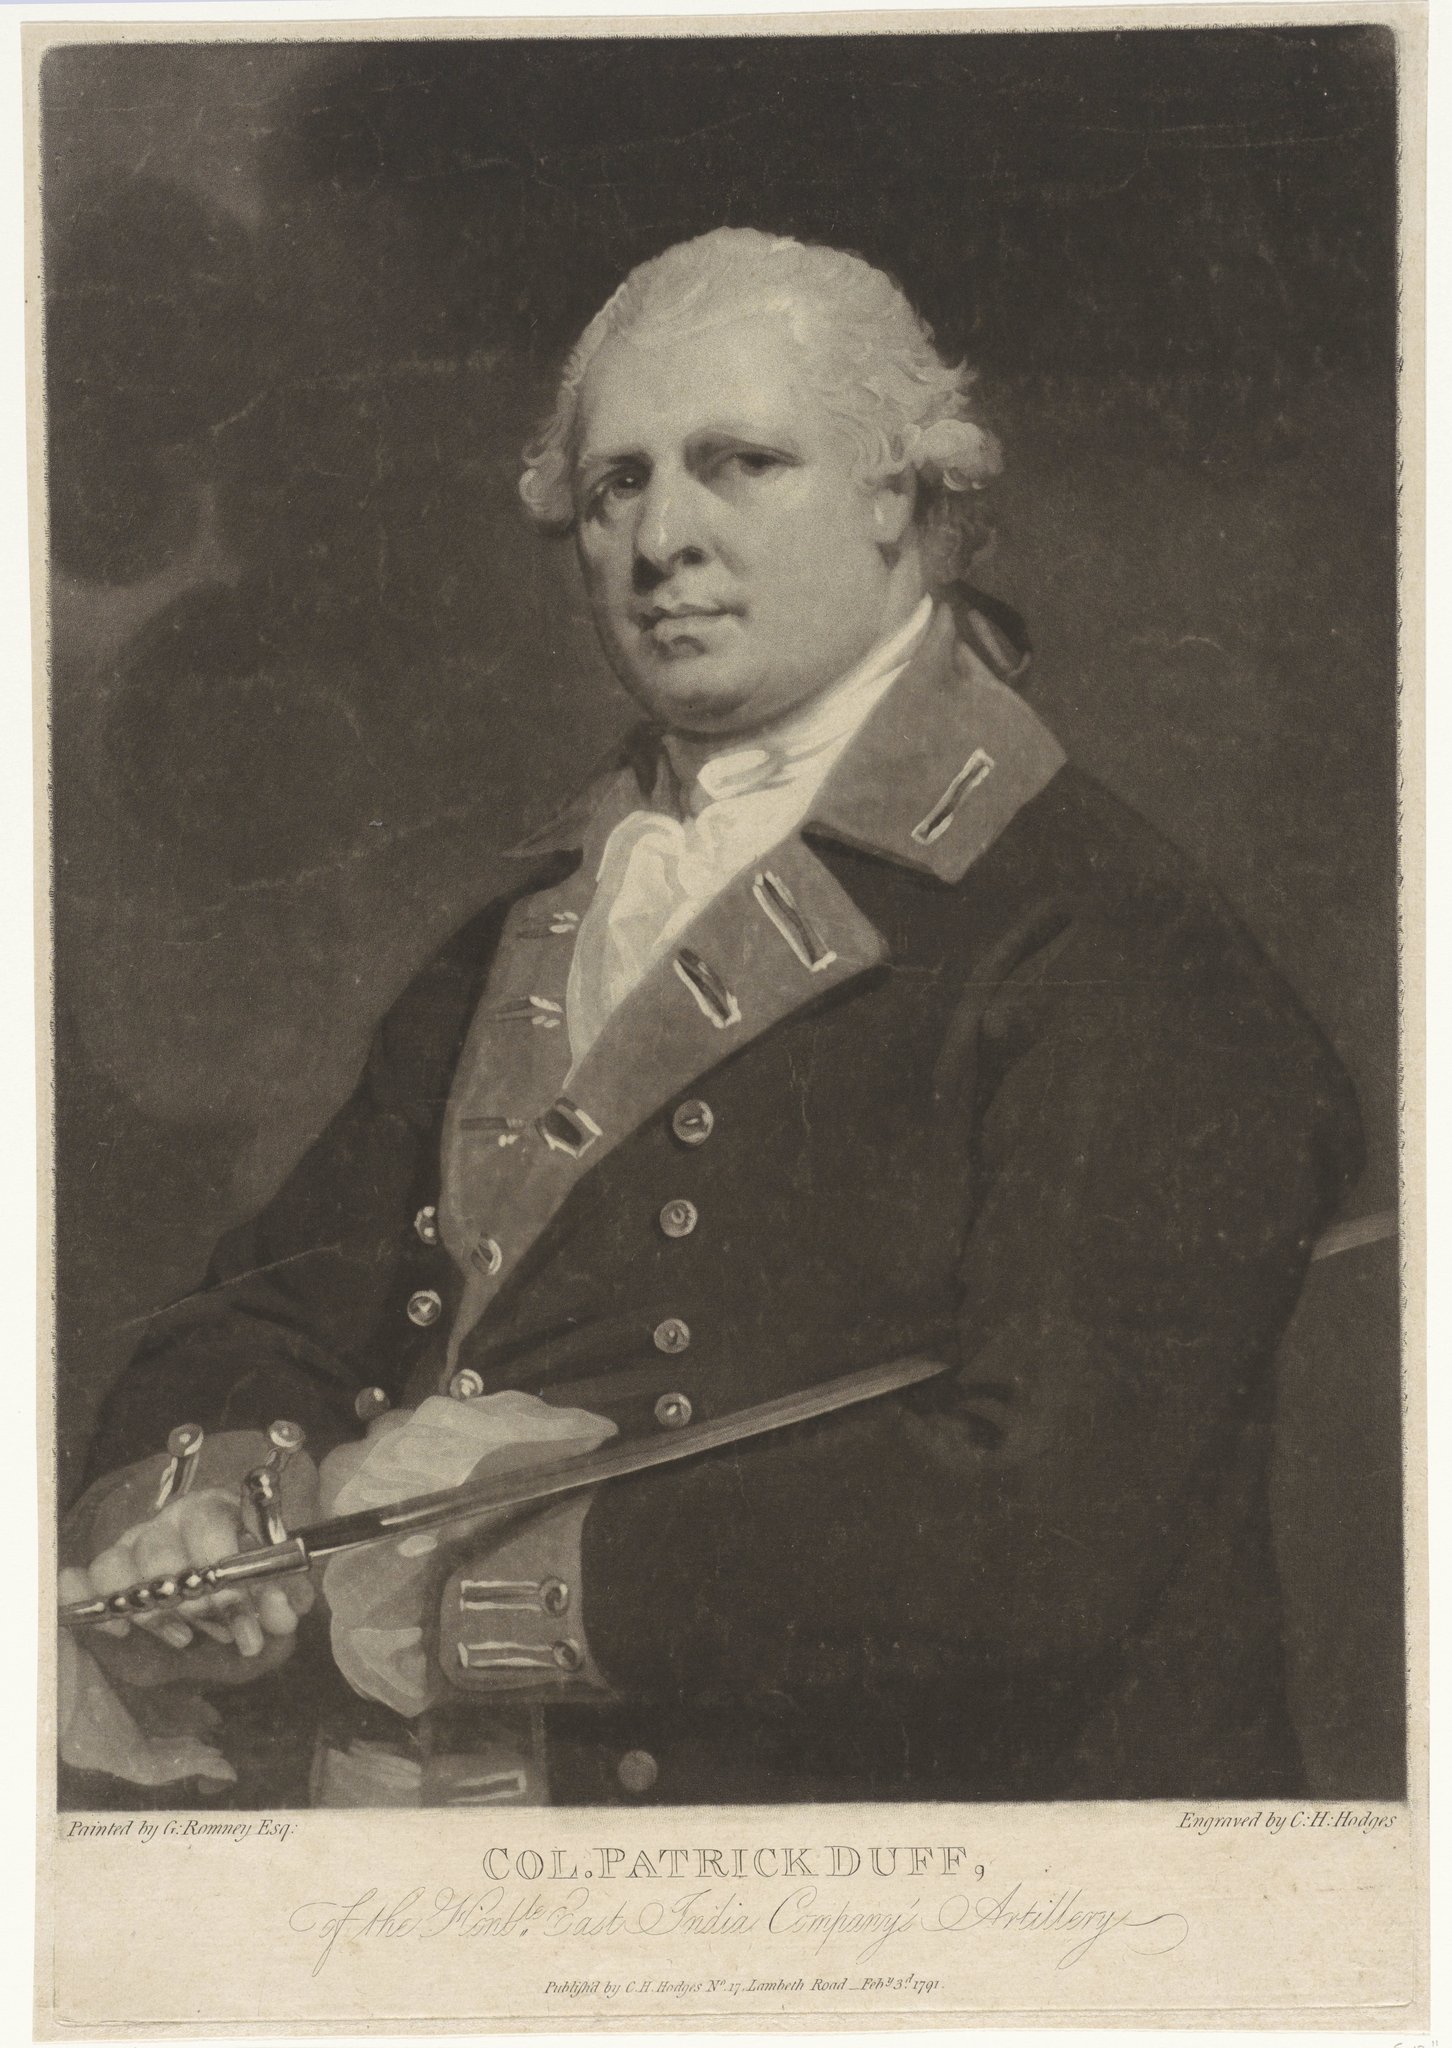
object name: print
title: Portret van Patrick Duff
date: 1791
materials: paper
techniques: engraving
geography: england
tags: hacking and thrusting weapons: sword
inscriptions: collector's mark: Lugt 2228